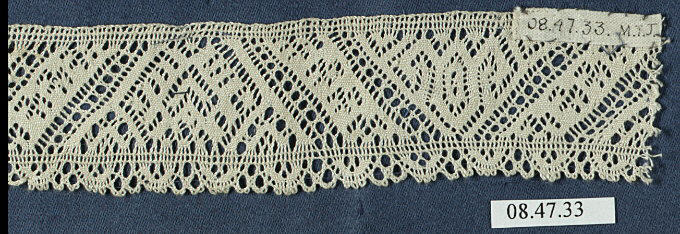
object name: fragment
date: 1801-1900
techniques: lace